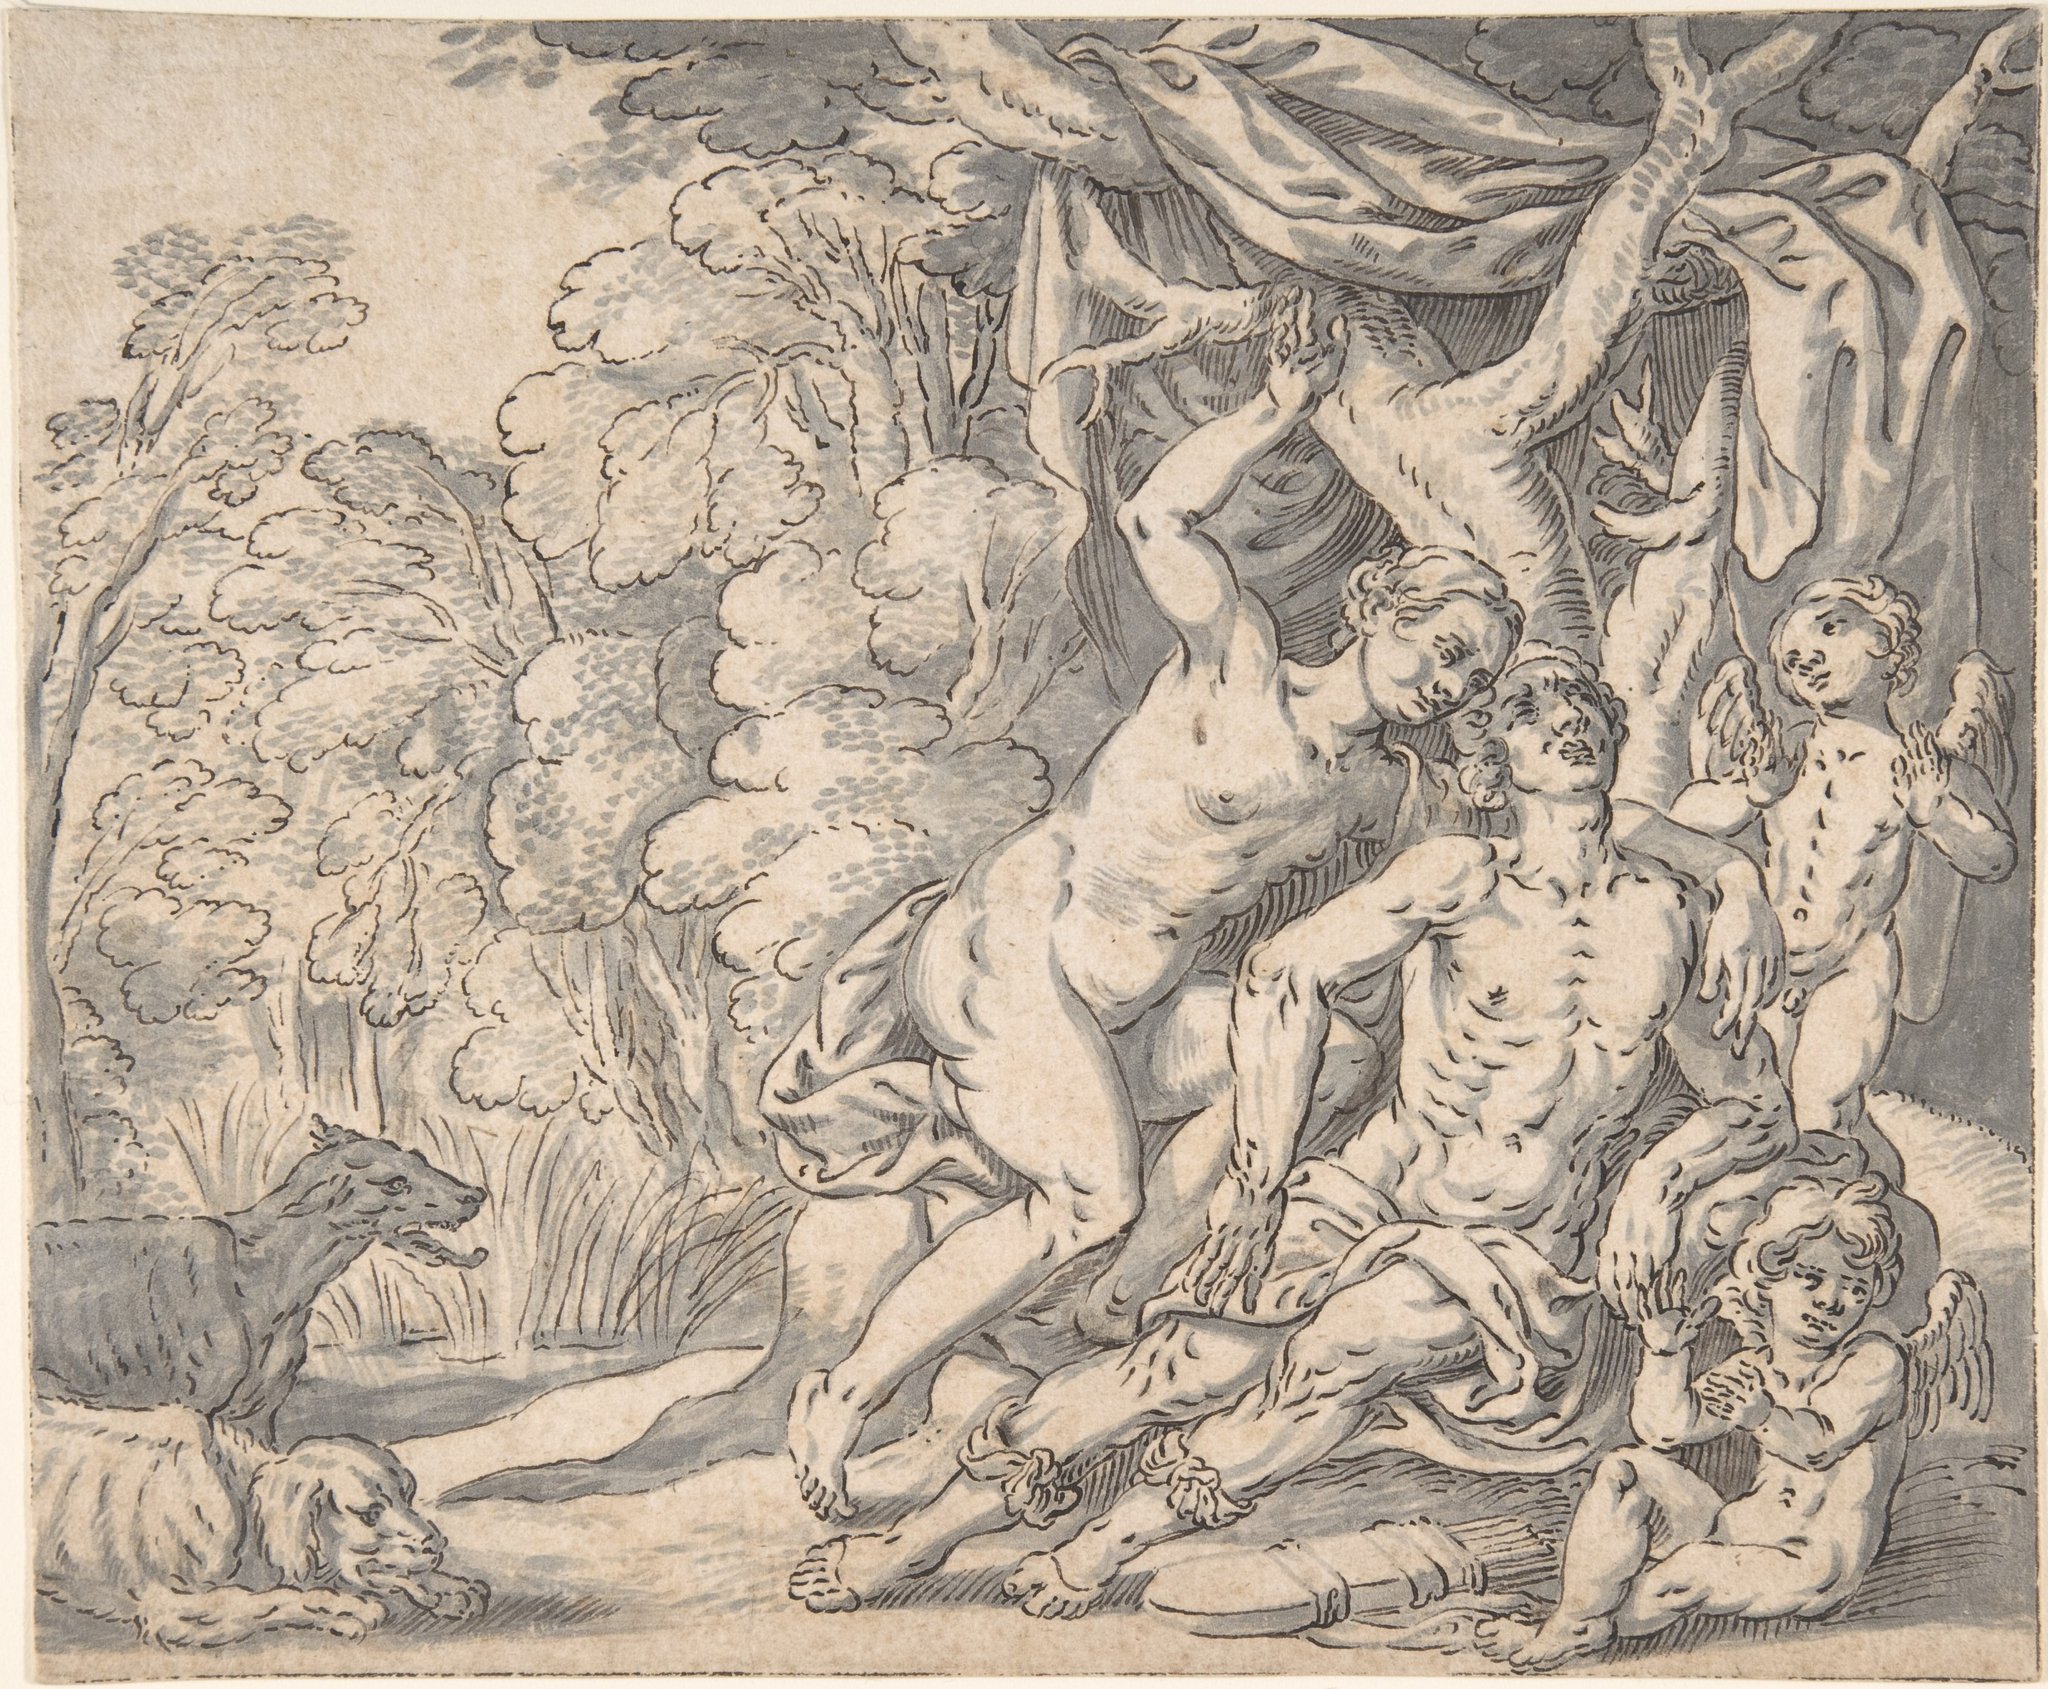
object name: drawing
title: The Death of Adonis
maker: johann könig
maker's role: artist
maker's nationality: german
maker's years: 1586-1642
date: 1625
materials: ink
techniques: brush, pen, wash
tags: adonis